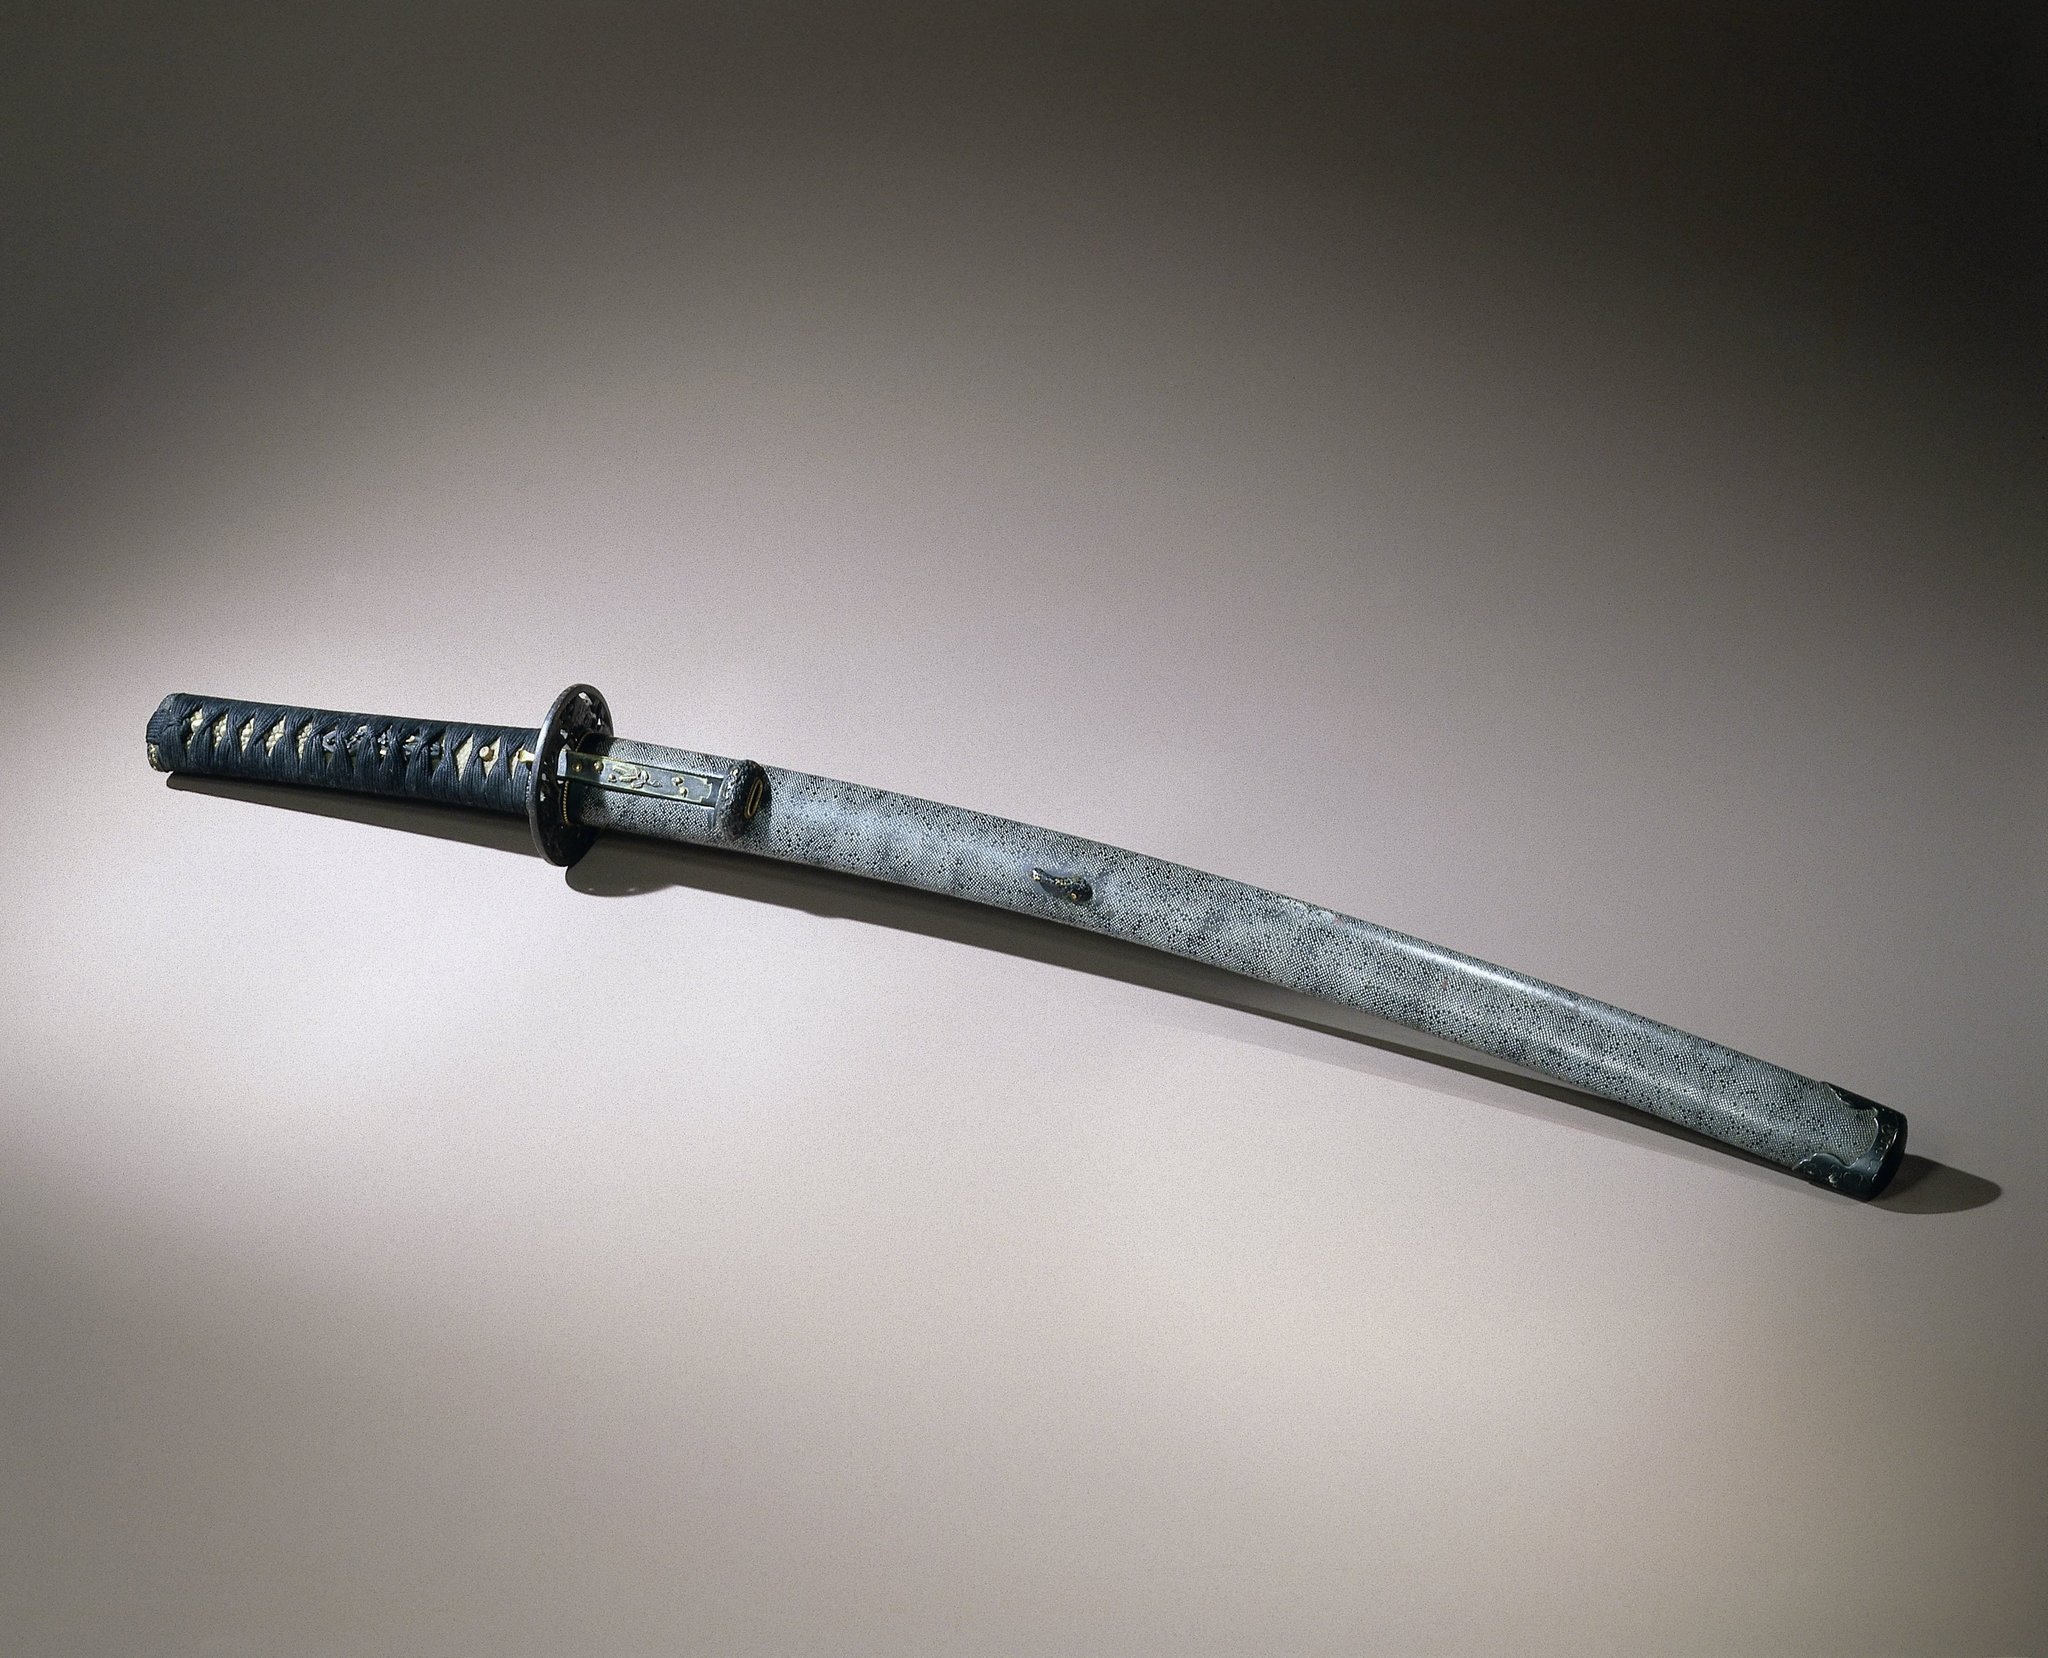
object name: wakizashi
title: Zwaard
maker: Anonymous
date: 1700-1800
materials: metal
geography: japan